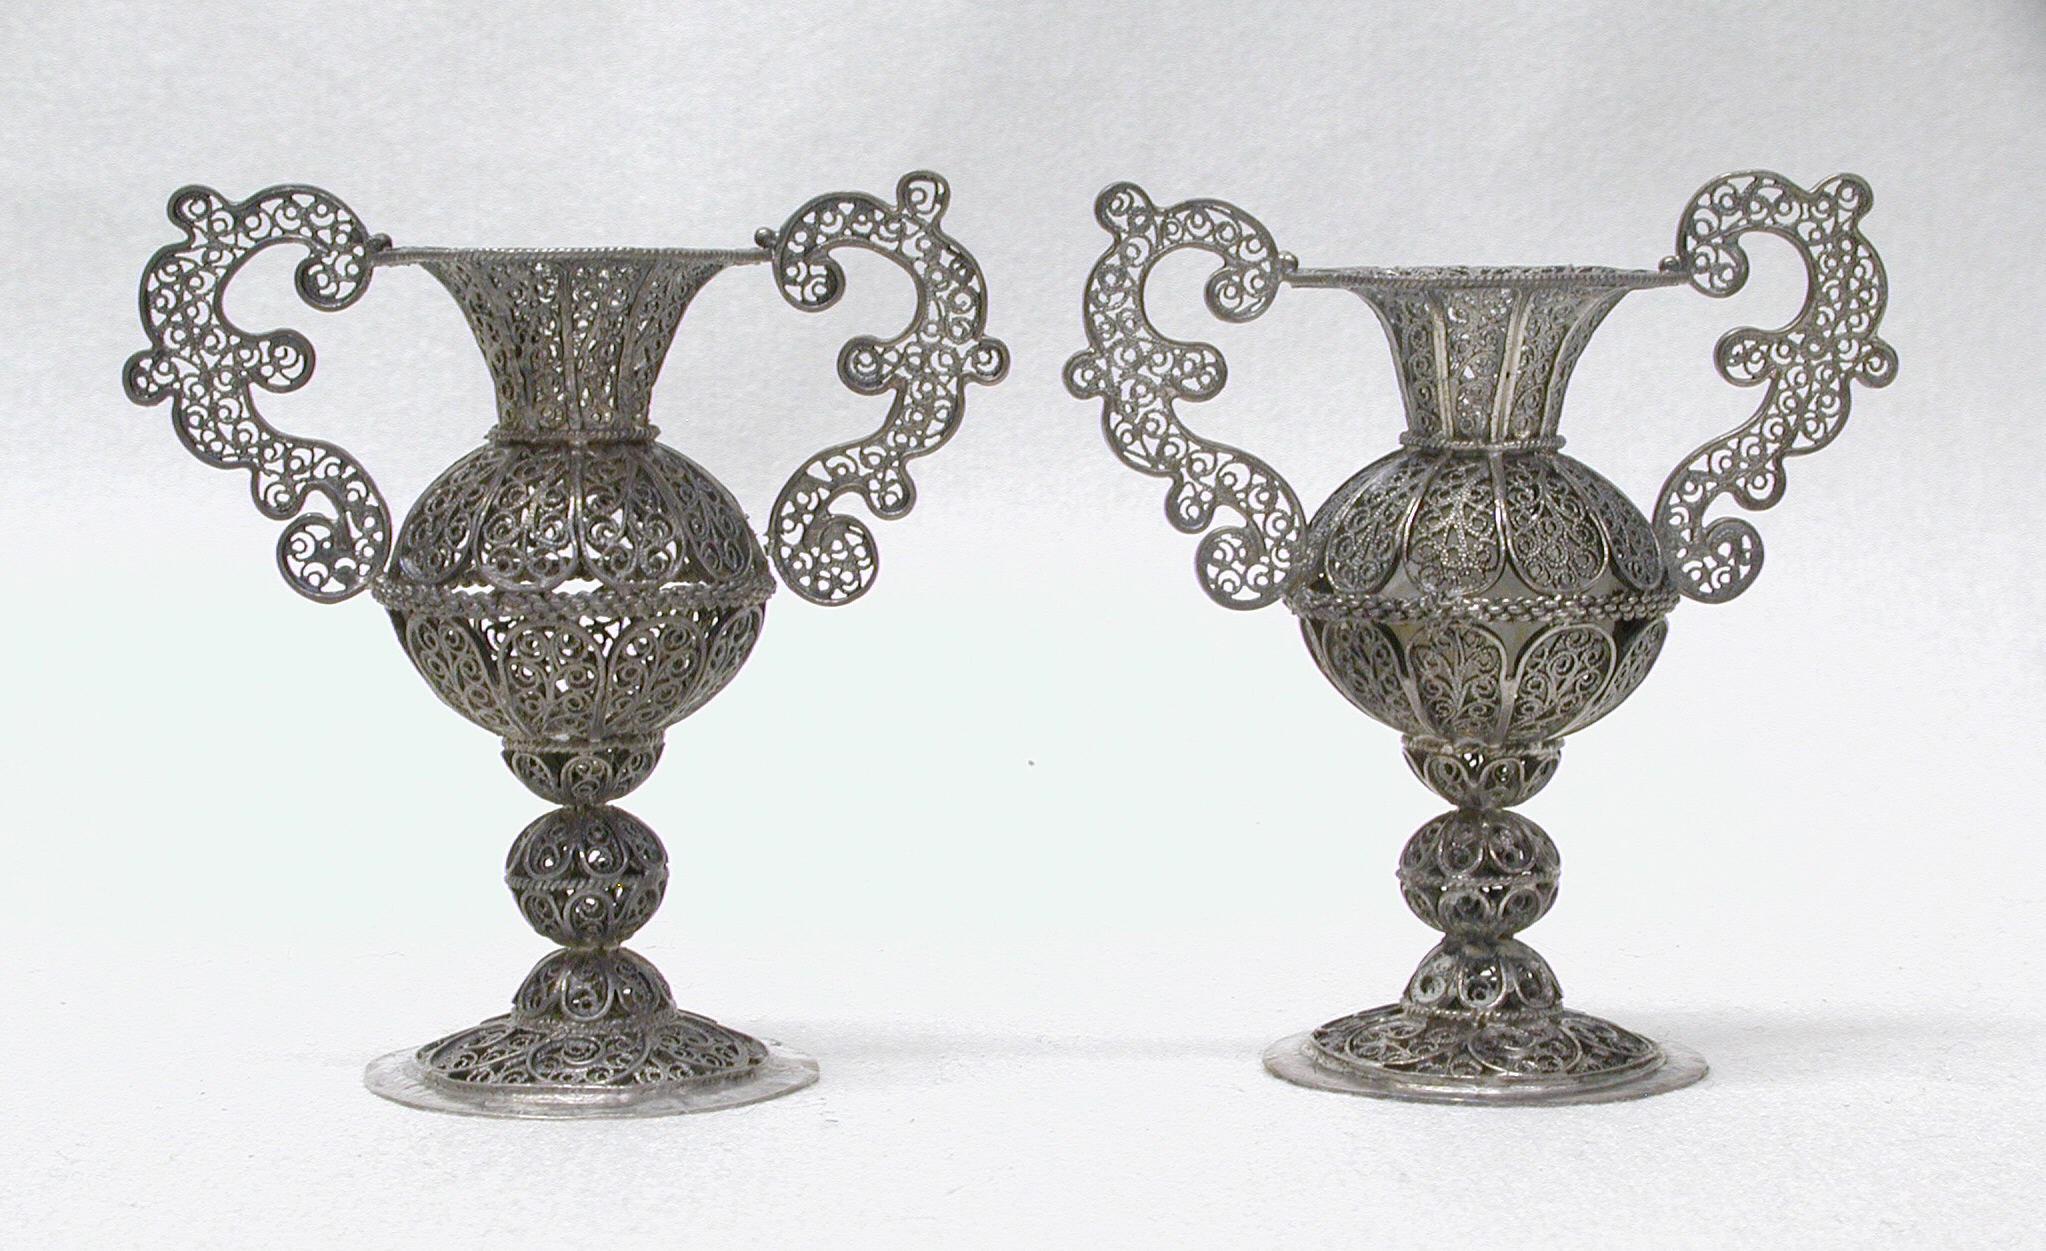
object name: urn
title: Miniature urn (one of a pair) (part of a set)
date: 1675-1700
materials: silver